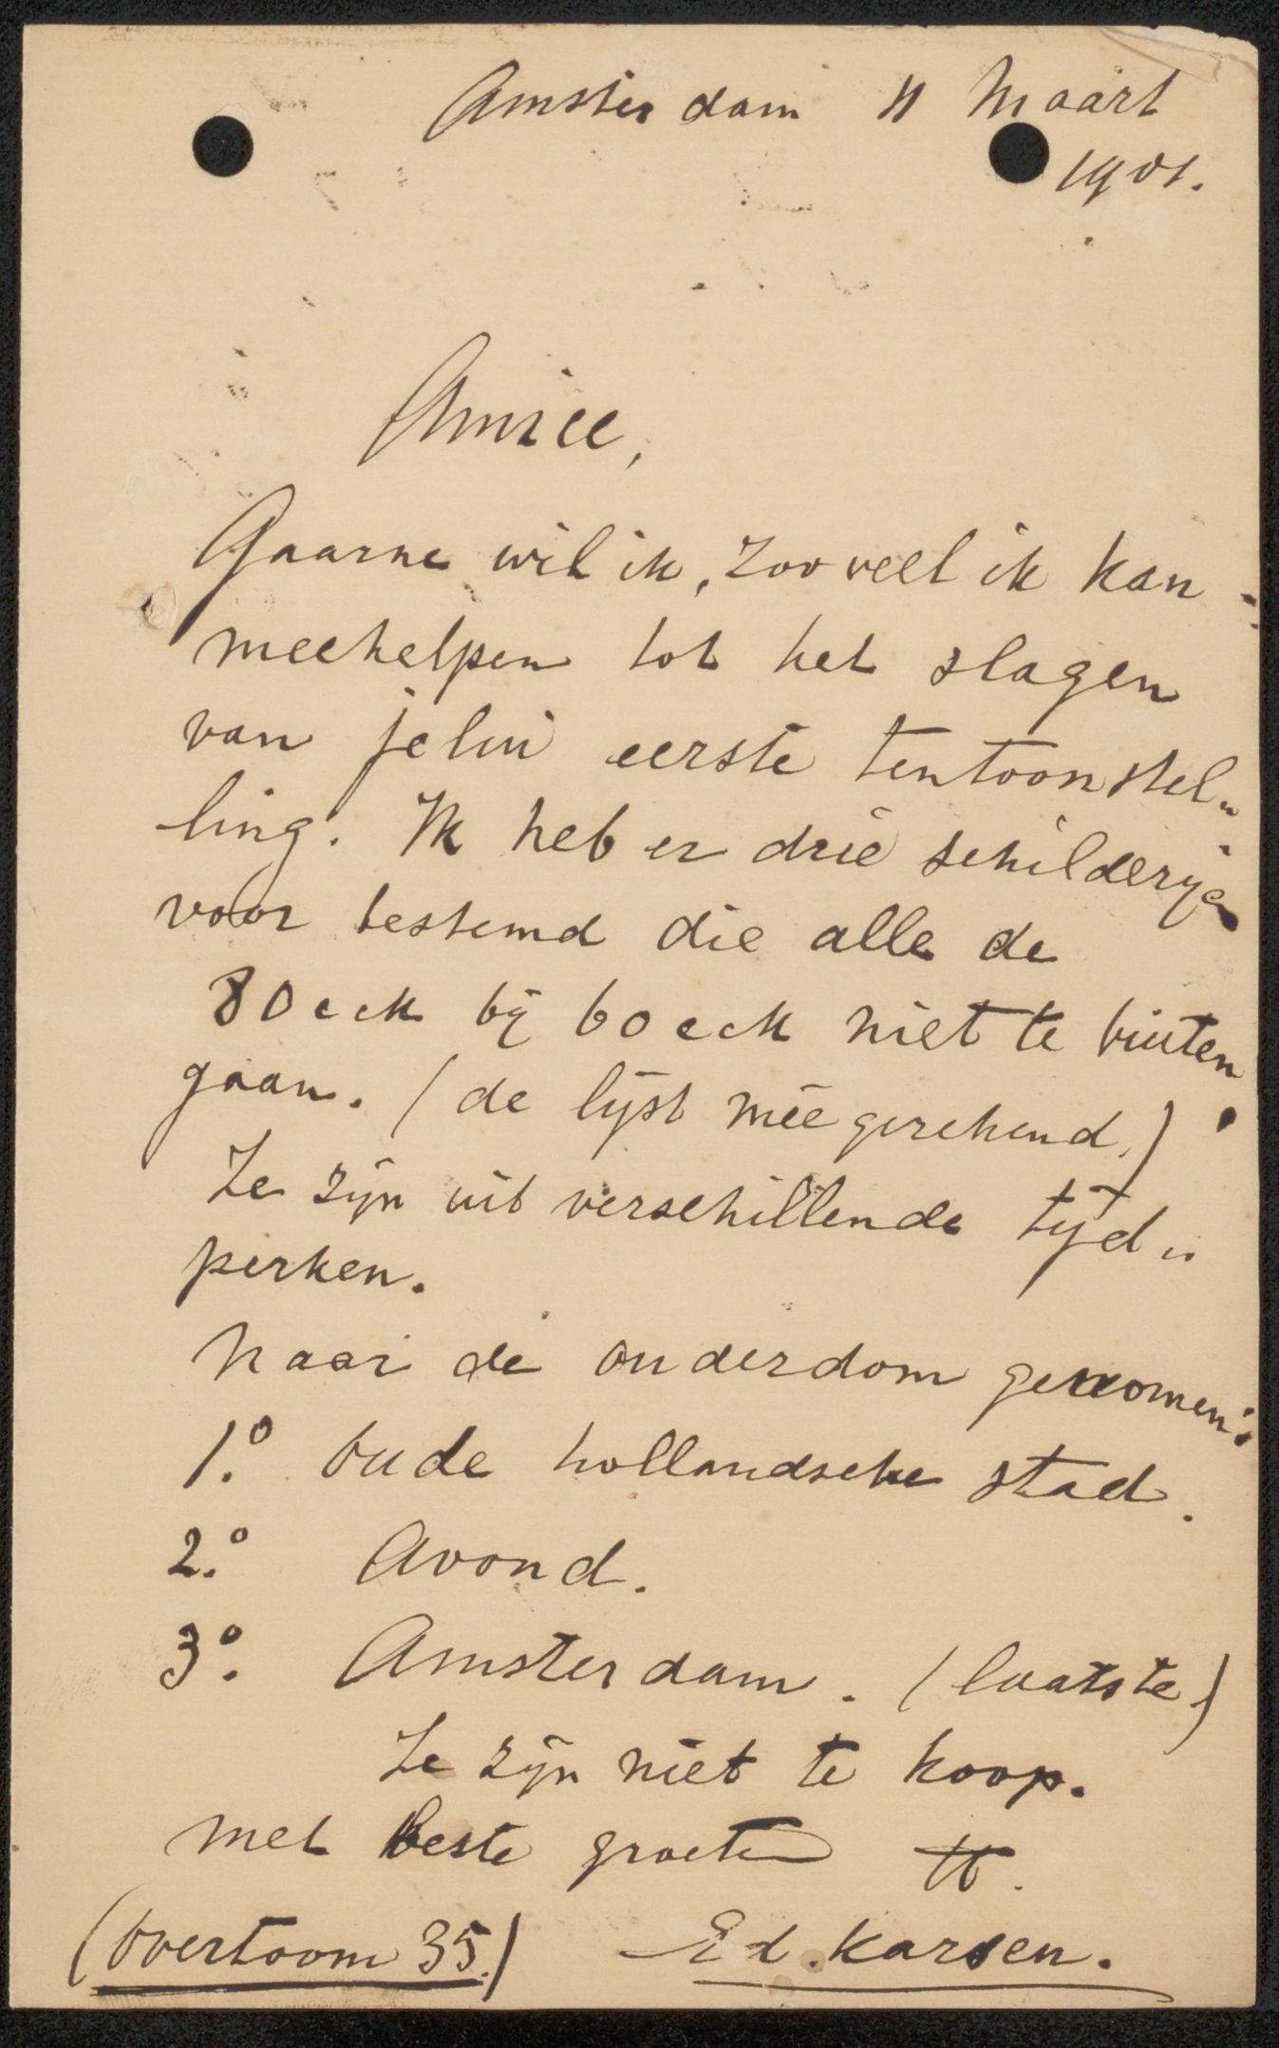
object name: letter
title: Brief aan Philip Zilcken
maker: eduard karsen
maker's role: draughtsman, painter, print maker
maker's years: 1860-1941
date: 1901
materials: ink, paper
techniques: pen, writing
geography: amsterdam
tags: the hague, philip zilcken, painting (including book-illumination, miniature-painting), exhibition ~ art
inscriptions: collector's mark: ‘RPK’